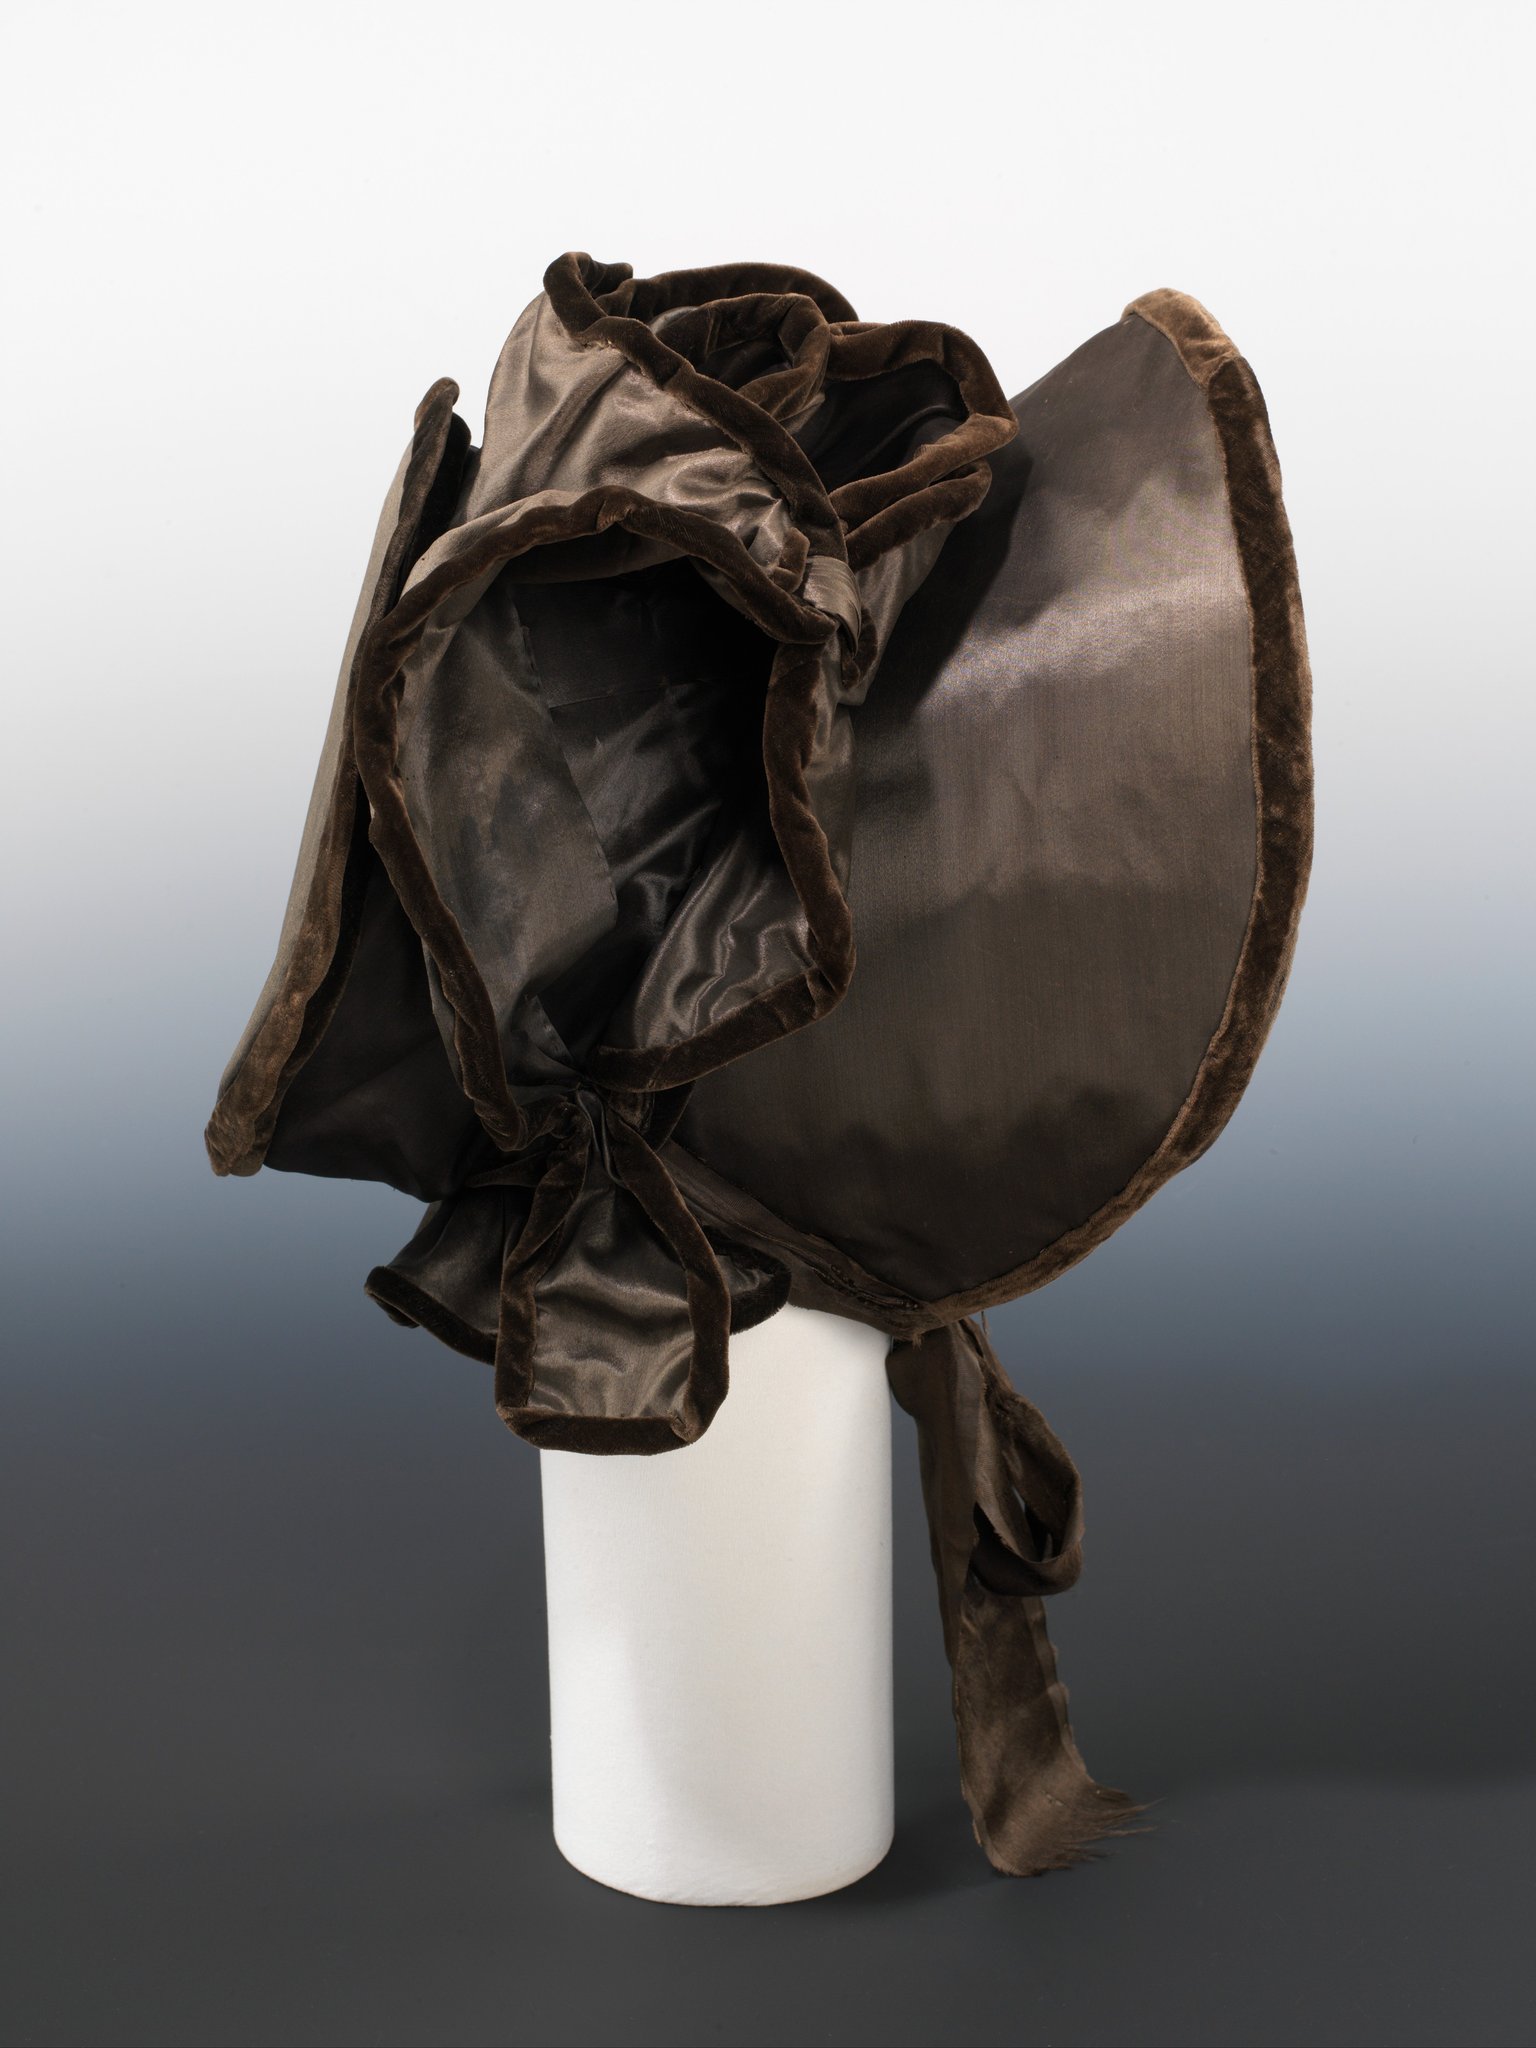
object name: bonnet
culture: british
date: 1820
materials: silk